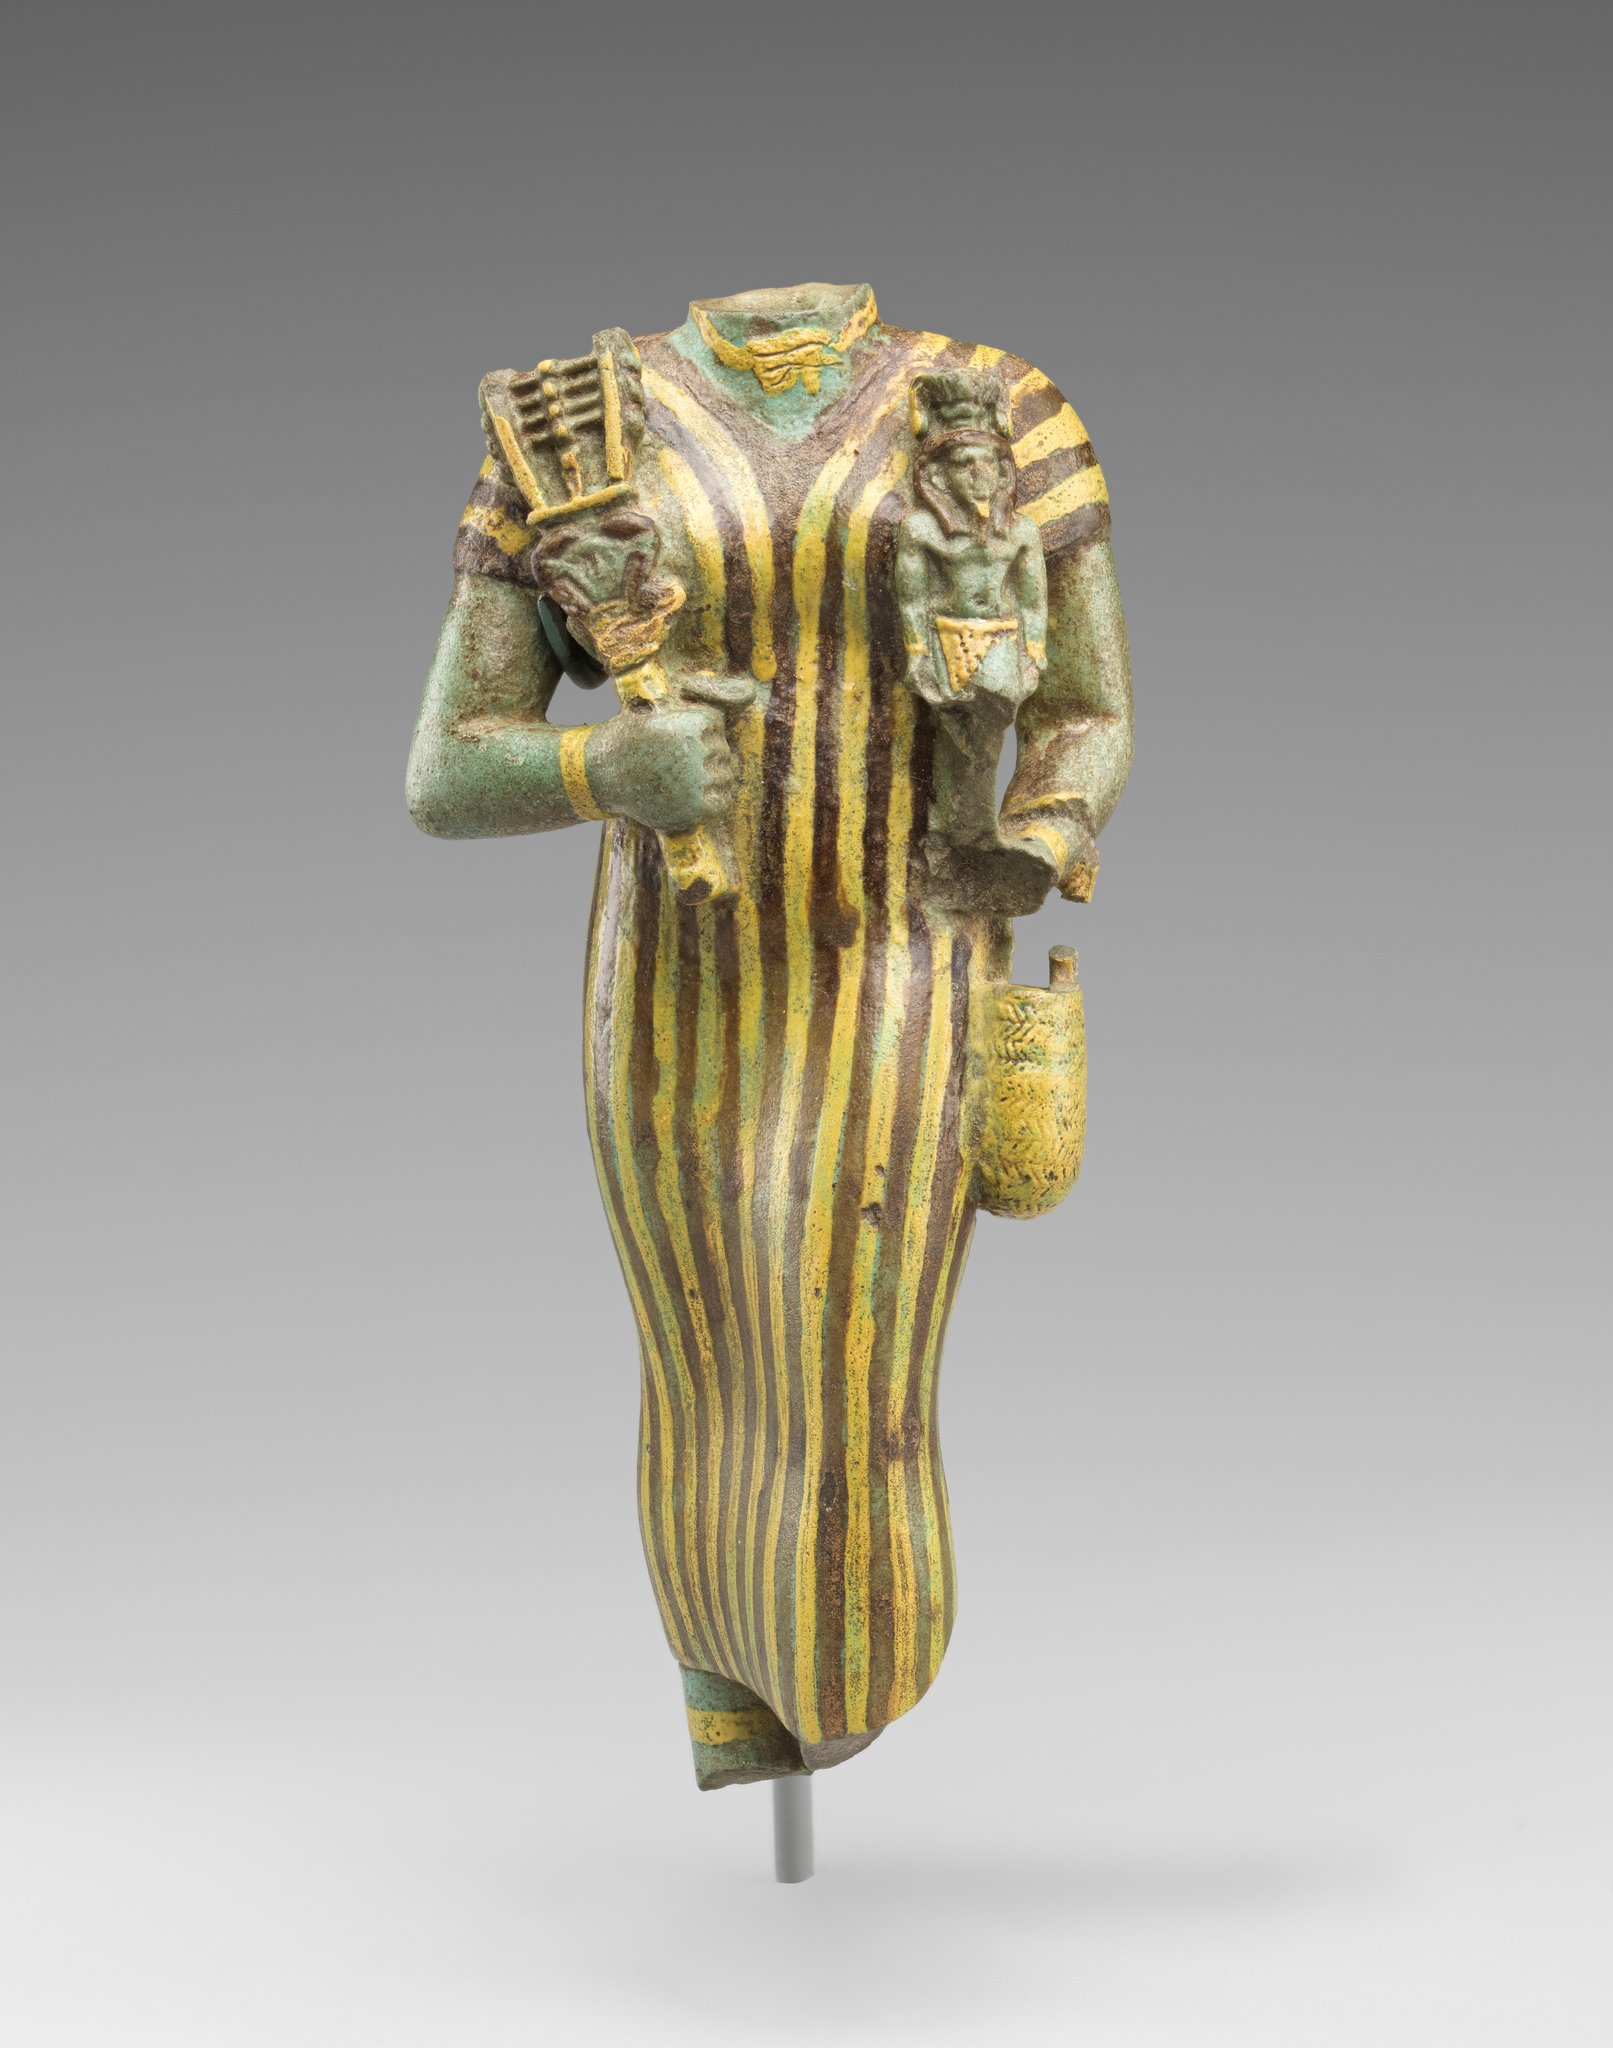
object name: bastet, nefertum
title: Statuette of Bastet holding a figure of Nefertum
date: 525-30 BCE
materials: faience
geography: egypt